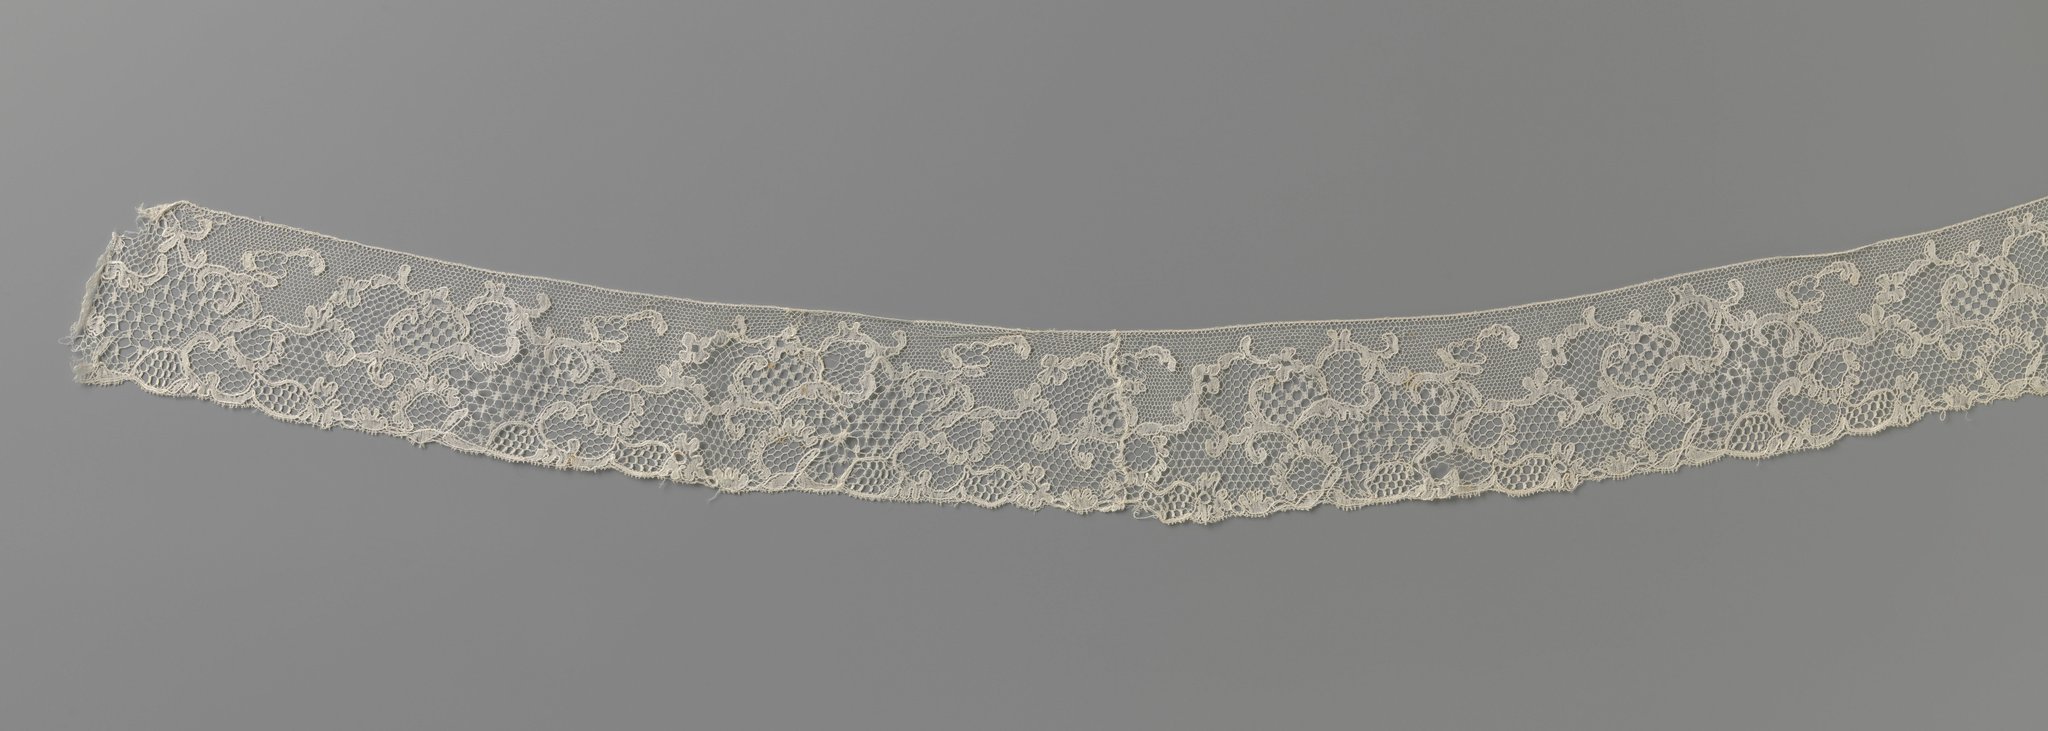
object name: strip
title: Strook kloskant met rocailles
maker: Anonymous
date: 1900-1949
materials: linen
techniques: lace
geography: tonderen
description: Strook naturelkleurige kloskant: Rijselse kant. Neo-rokoko patroon van rocailles of cartouches gevormd door grillige gevederde bladeren en enkele bloemen. De rocailles en cartouches liggen tegen elkaar aan en vullen het grootste deel van de strook, ze zijn gevuld met verschillende siergronden, waaronder rozengronden en grovere rasterwerkvullingen, waaronder een rasterwerkvulling versierd met vormslagen. De opeengestapelde motieven zijn aan de bovenzijde van de strook met elkaar verbonden door een tulegrond. De bovenzijde van de strook is recht afgewerkt. De flauwe schulpenrand langs de onderzijde is afgewerkt met picots.